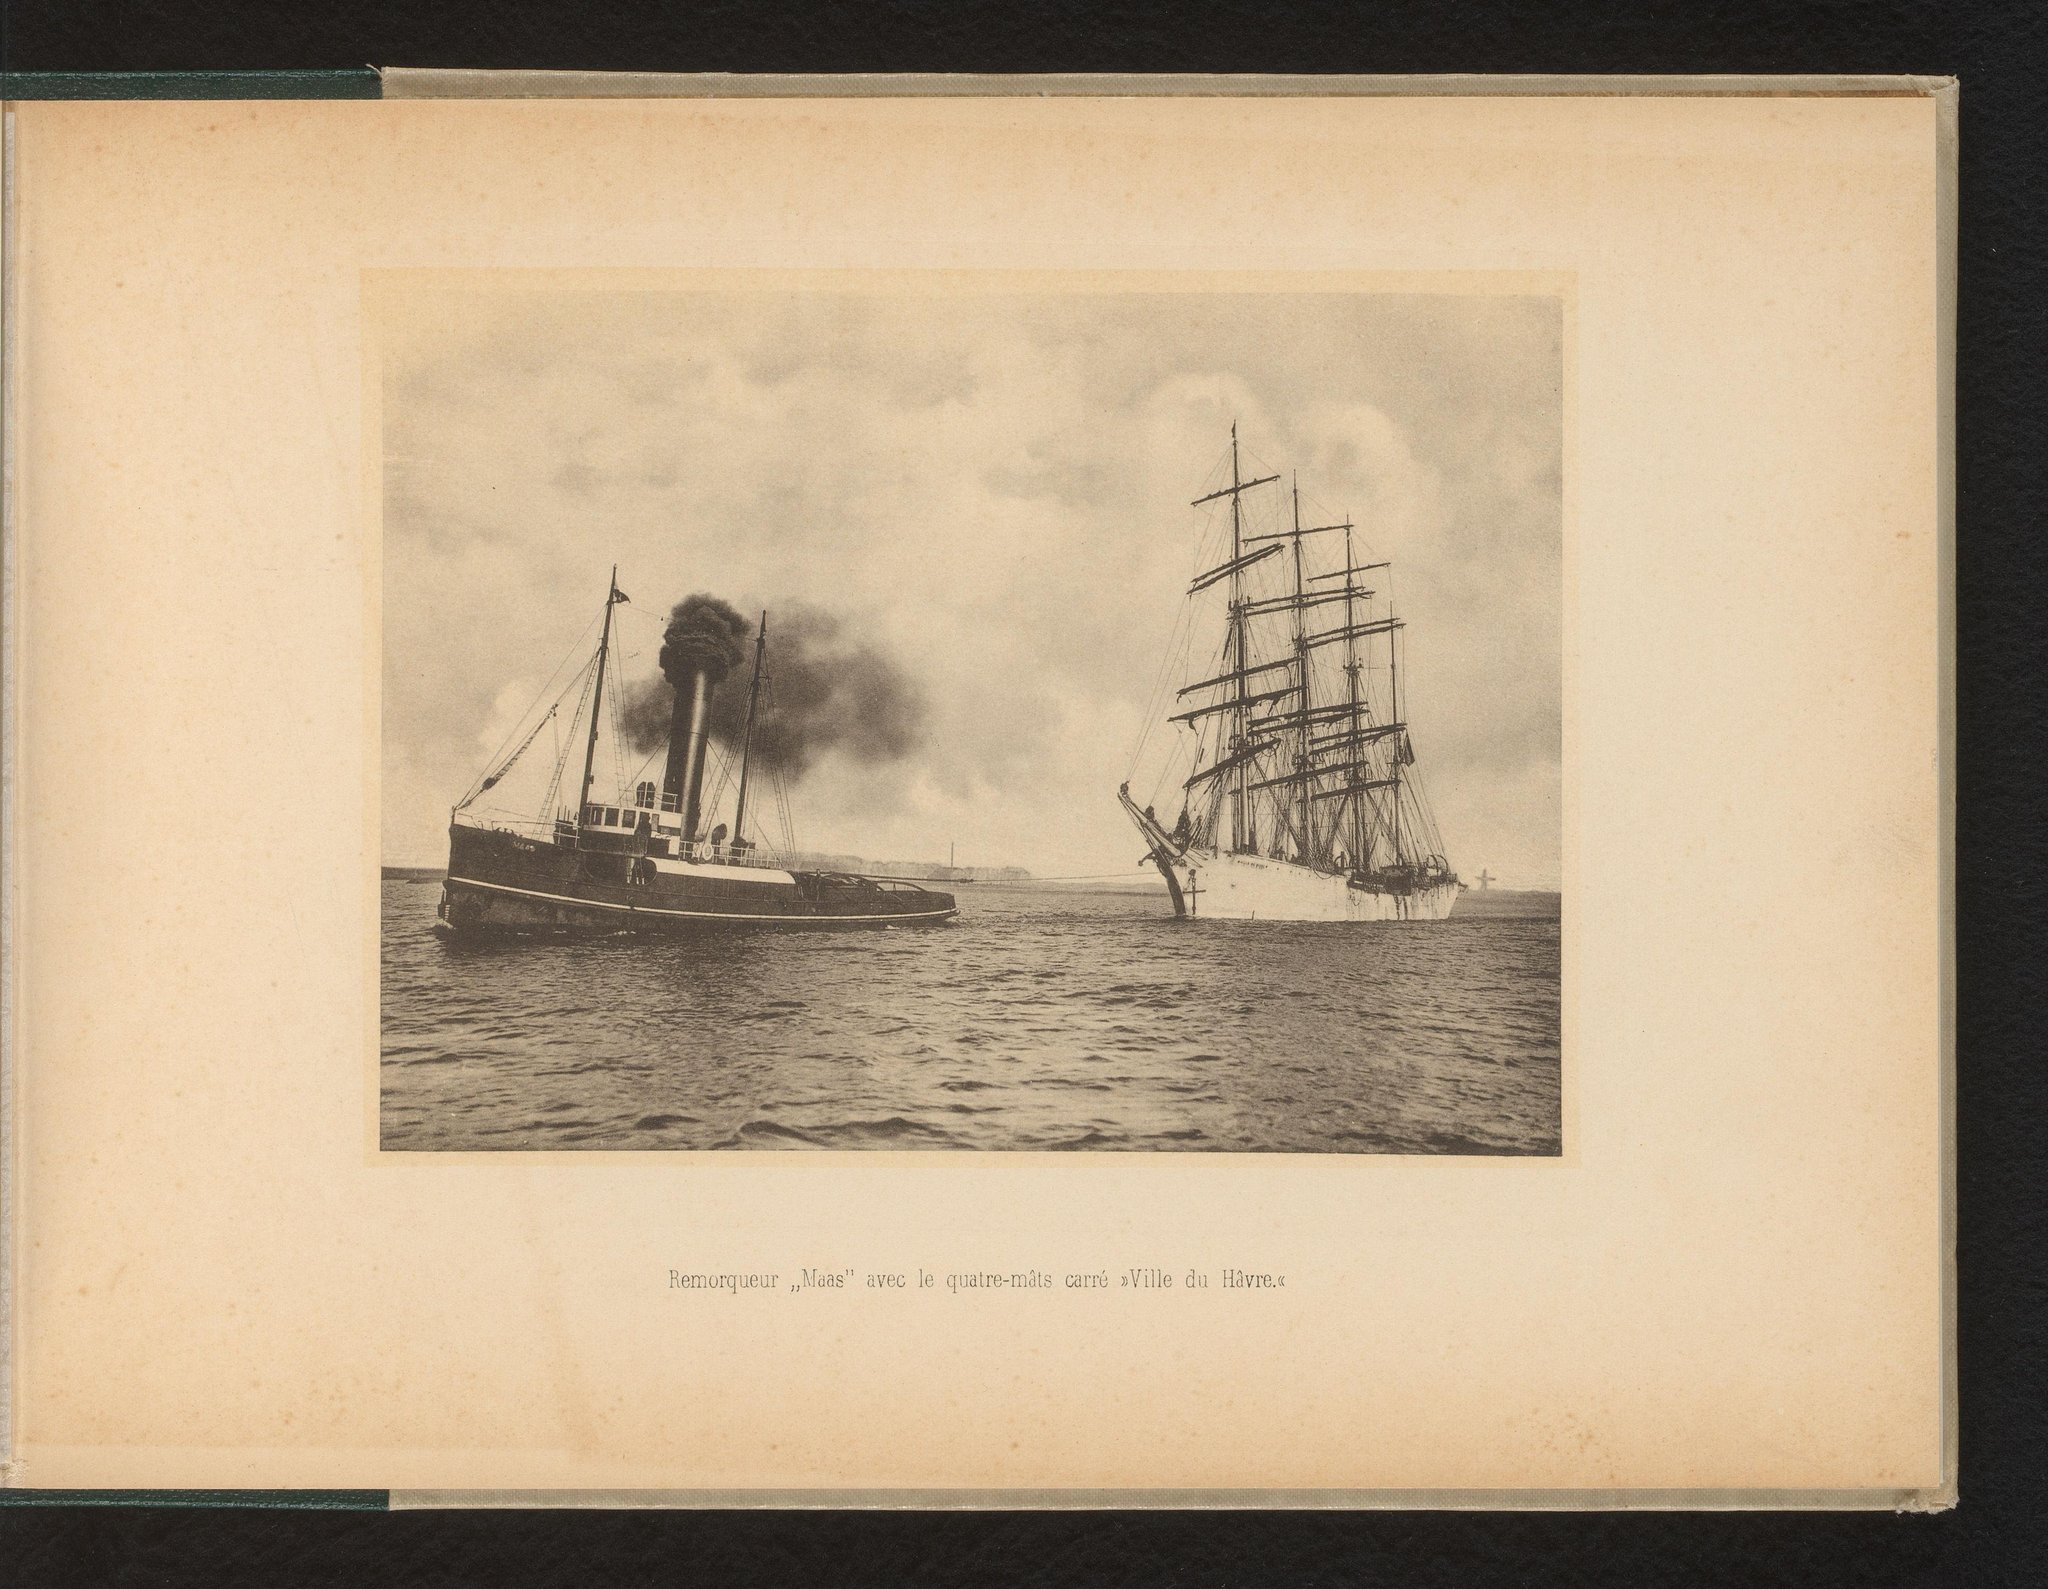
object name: photomechanical print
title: Sleepboot Maasen en de viermaster Ville du Hâvre in de haven van Rotterdam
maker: Anonymous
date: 1902-1907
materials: paper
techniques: photograph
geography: rotterdam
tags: harbour, rotterdam